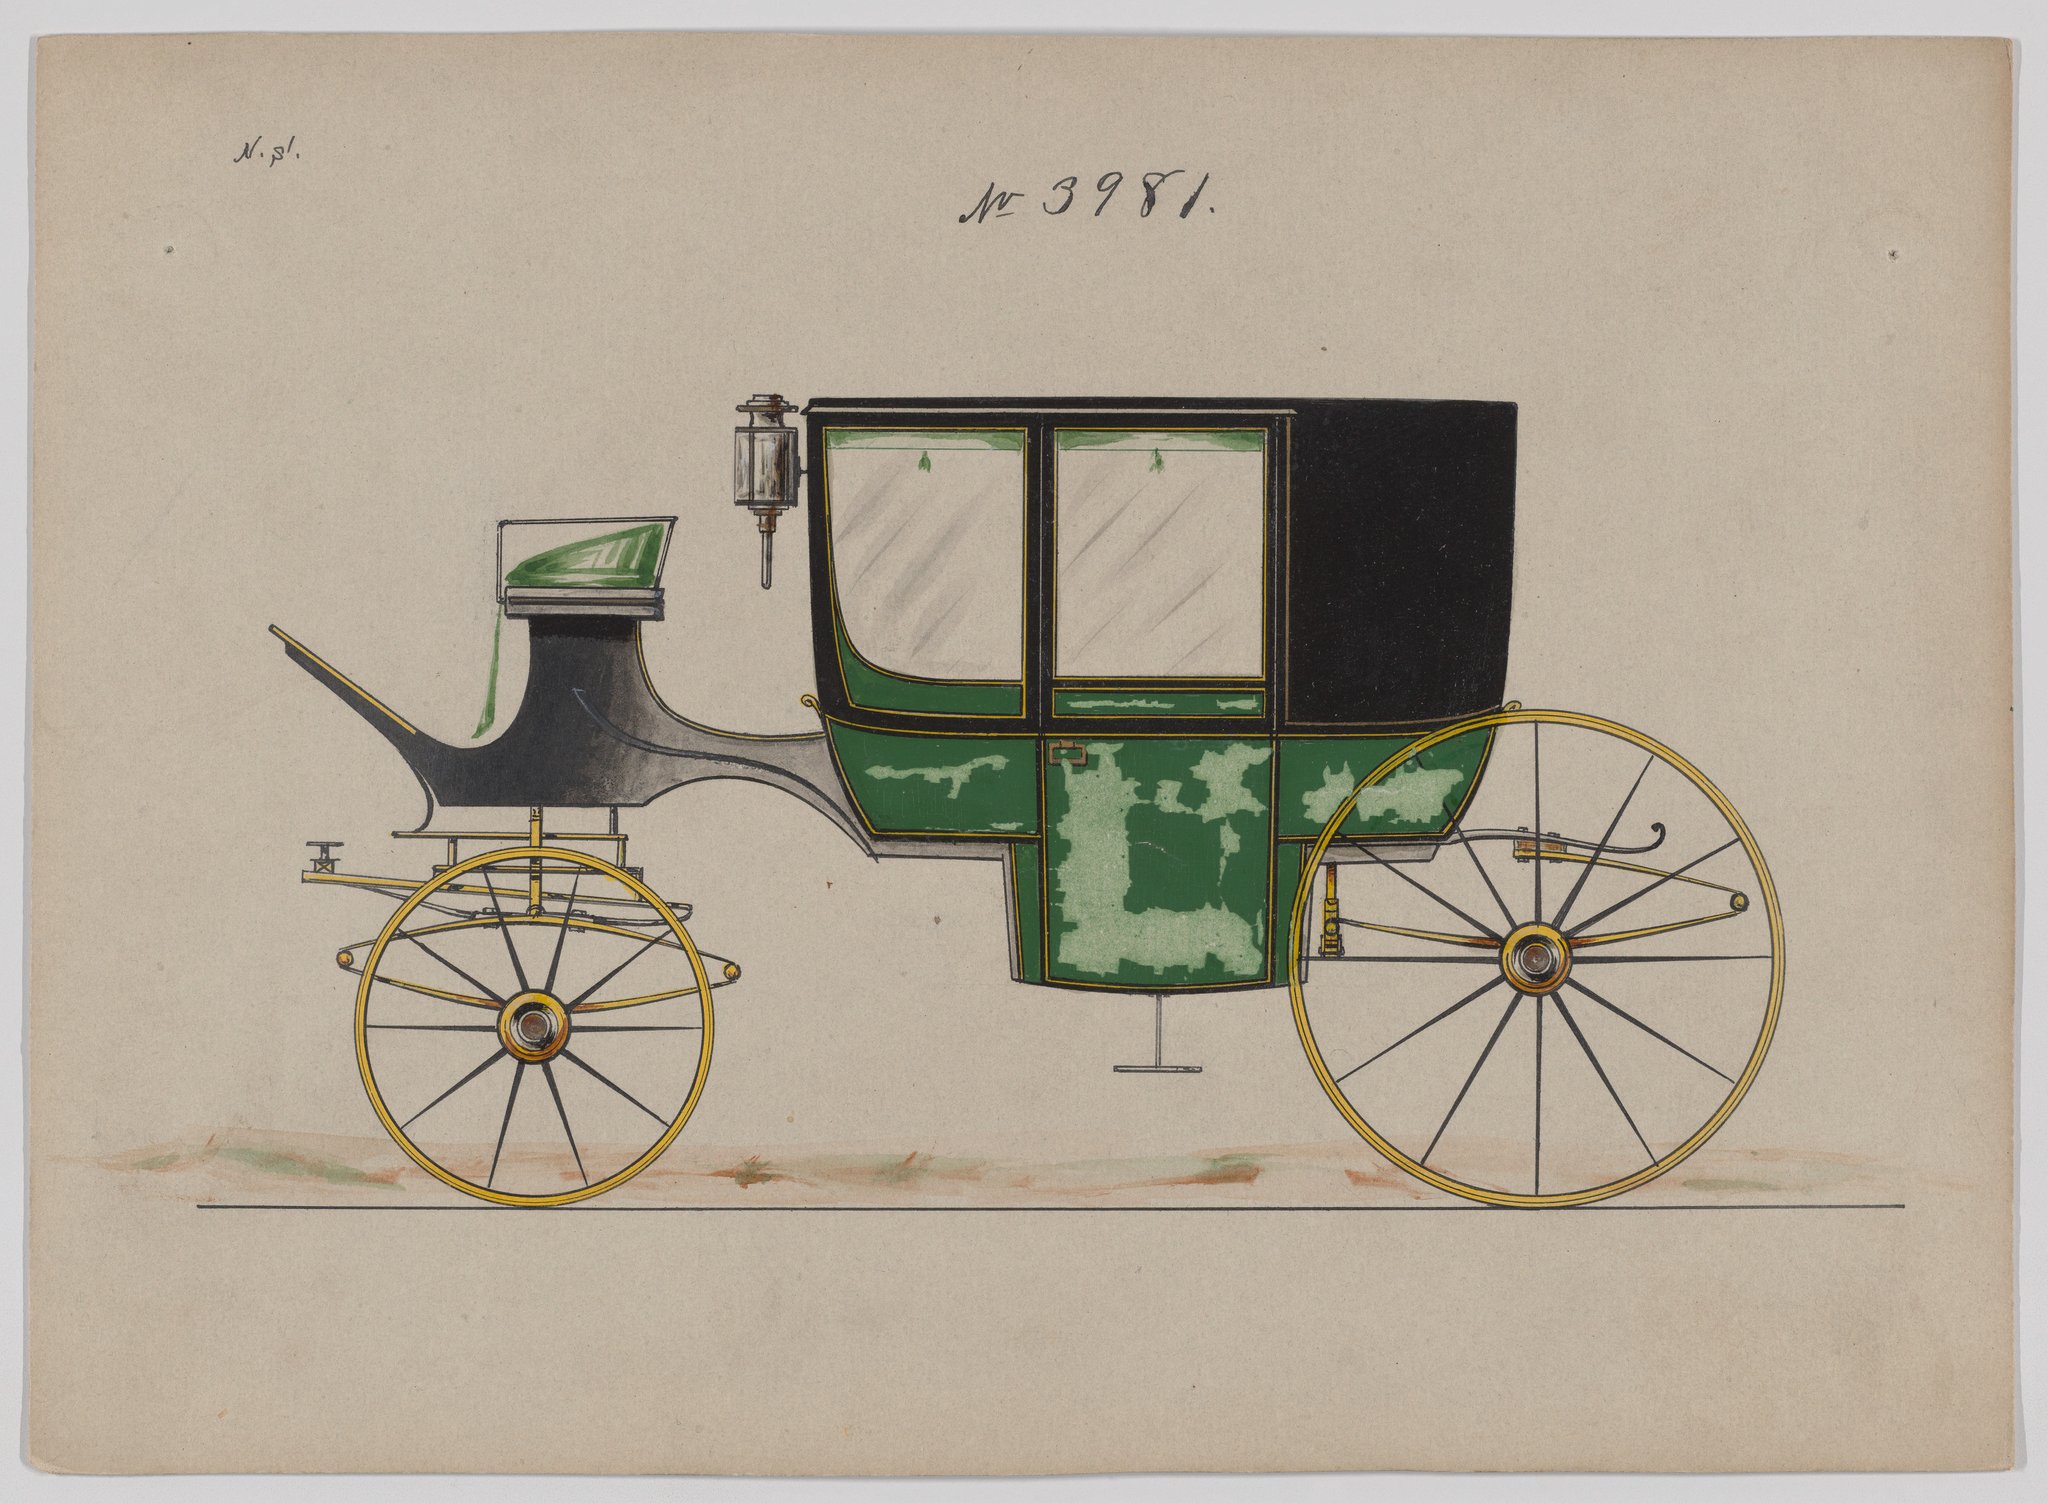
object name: drawing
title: Coach #3981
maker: brewster & co.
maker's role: manufacturer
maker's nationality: american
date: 1886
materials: gouache, graphite, gum arabic, ink, watercolor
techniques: pen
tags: carriages